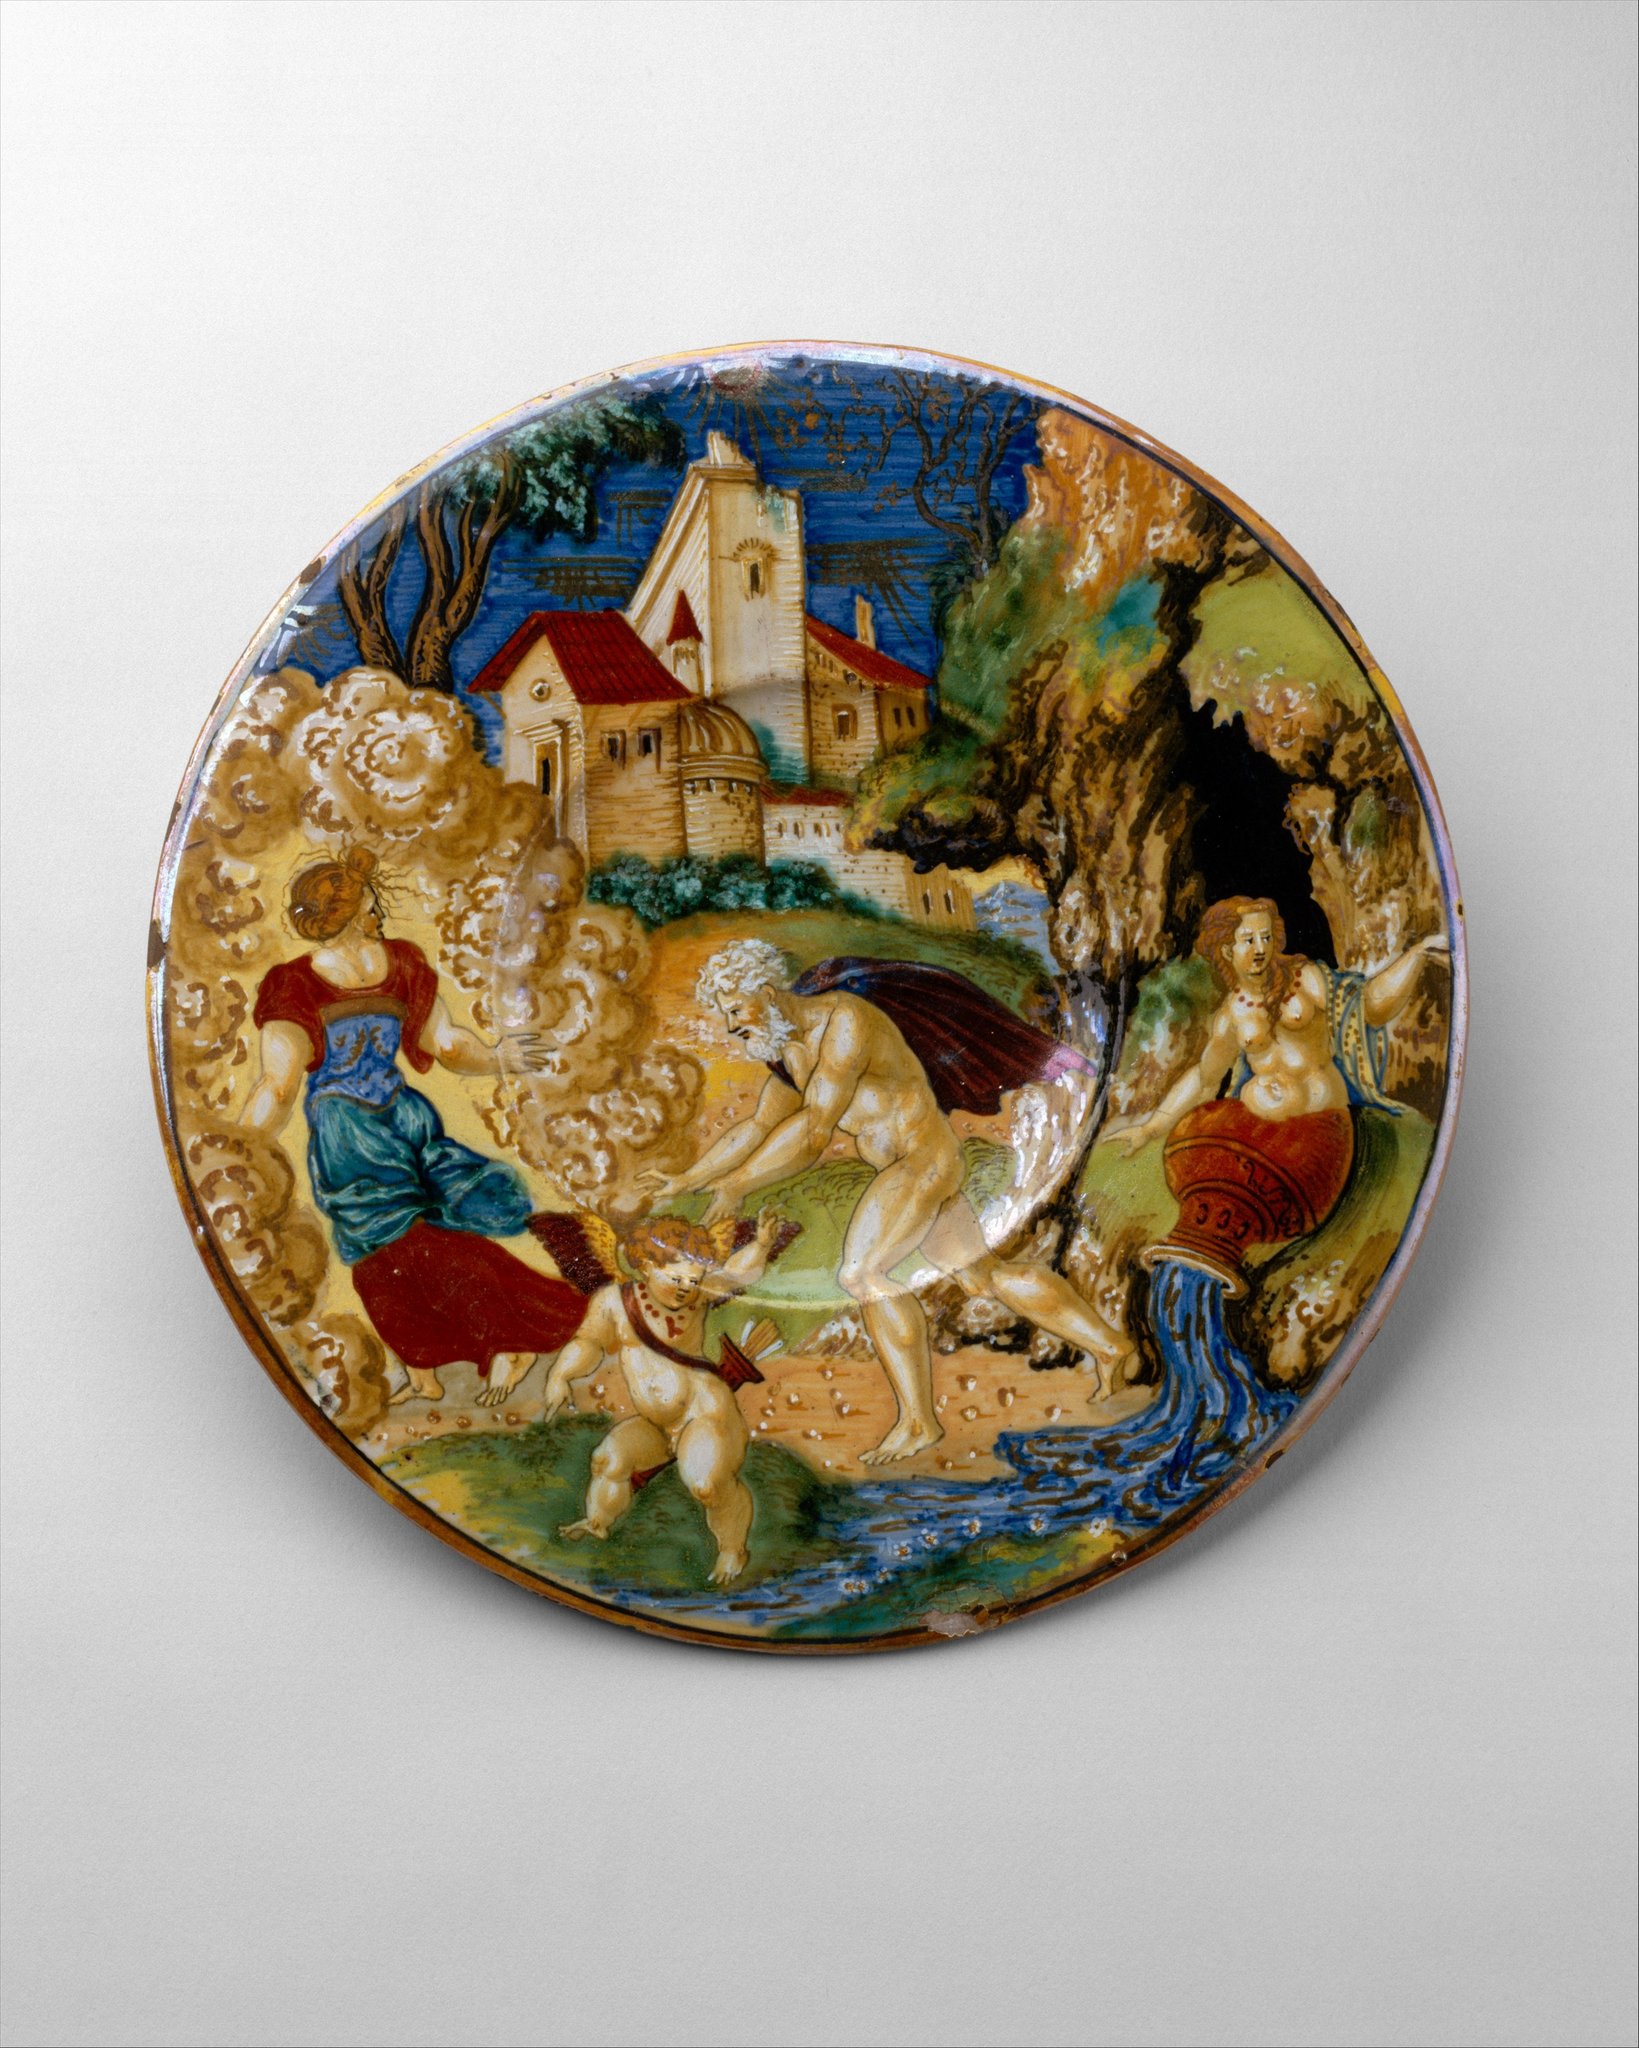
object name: plate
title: Plate (tagliere)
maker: francesco xanto avelli da rovigo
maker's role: artist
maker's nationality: italian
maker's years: 1482-1542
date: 1534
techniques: maiolica, glazing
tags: male nudes,women,female nudes,cupid